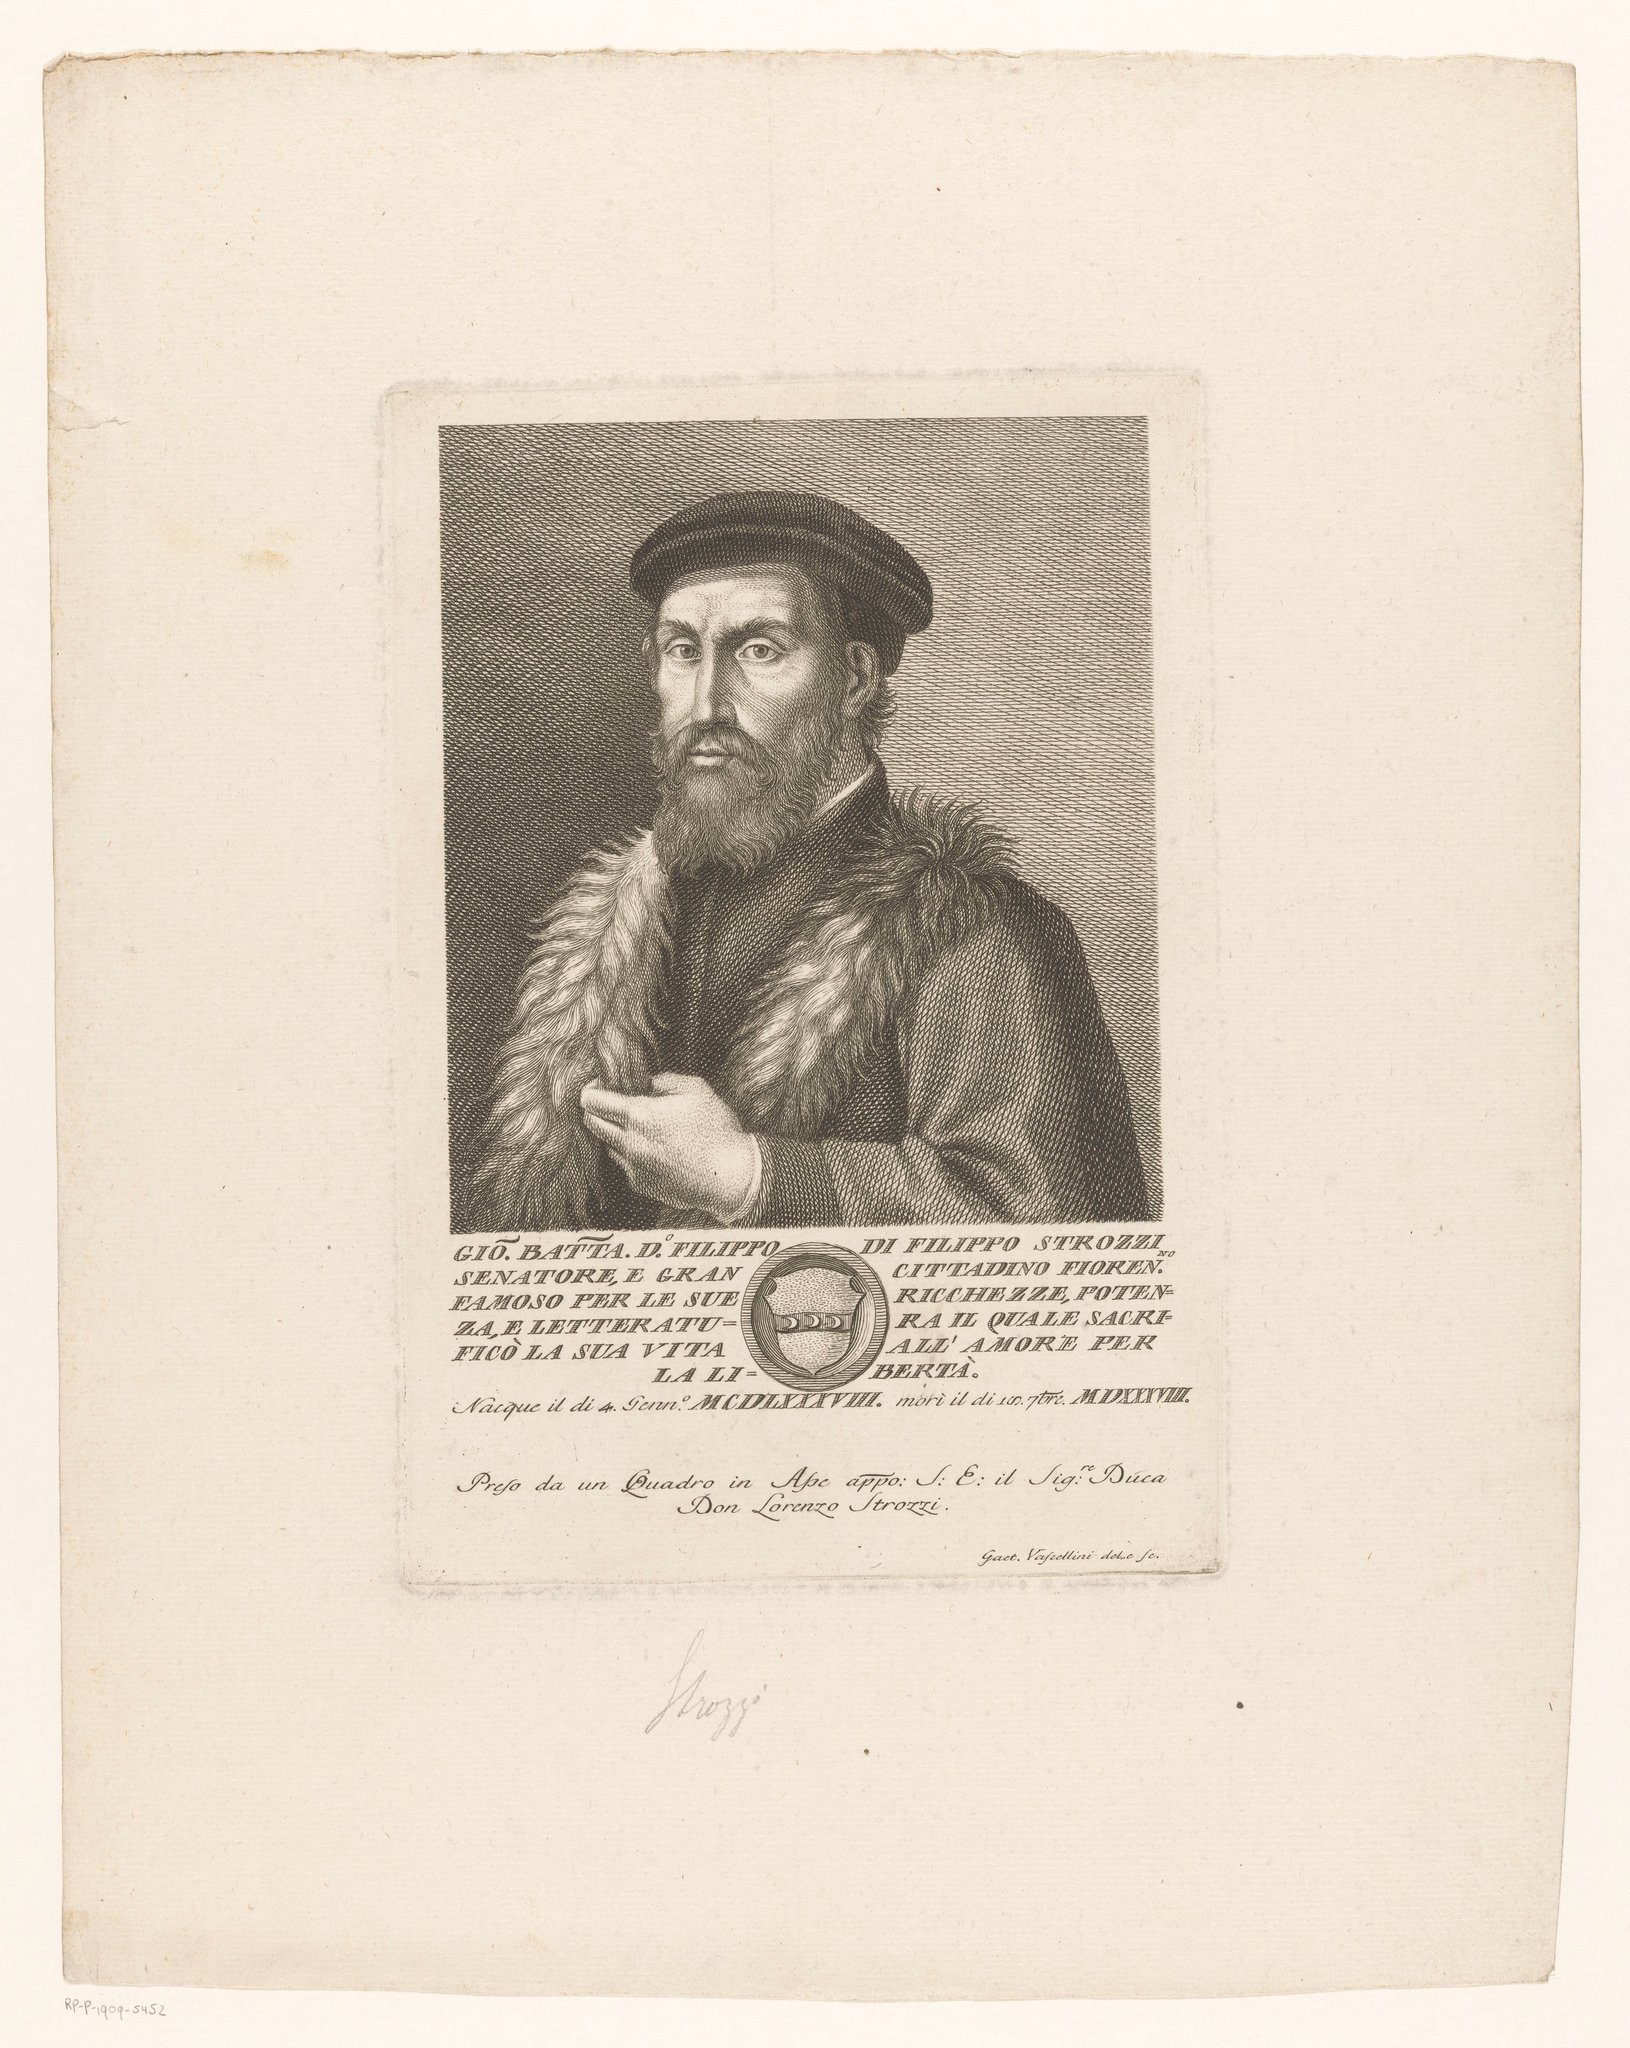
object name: print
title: Portret van Filippo Strozzi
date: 1755-1805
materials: paper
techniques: engraving, etching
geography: italy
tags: politician, historical persons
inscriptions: collector's mark: Lugt 2228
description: Onder het portret een tekst in het Italiaans en een wapenschild in een cirkelvormig kader.